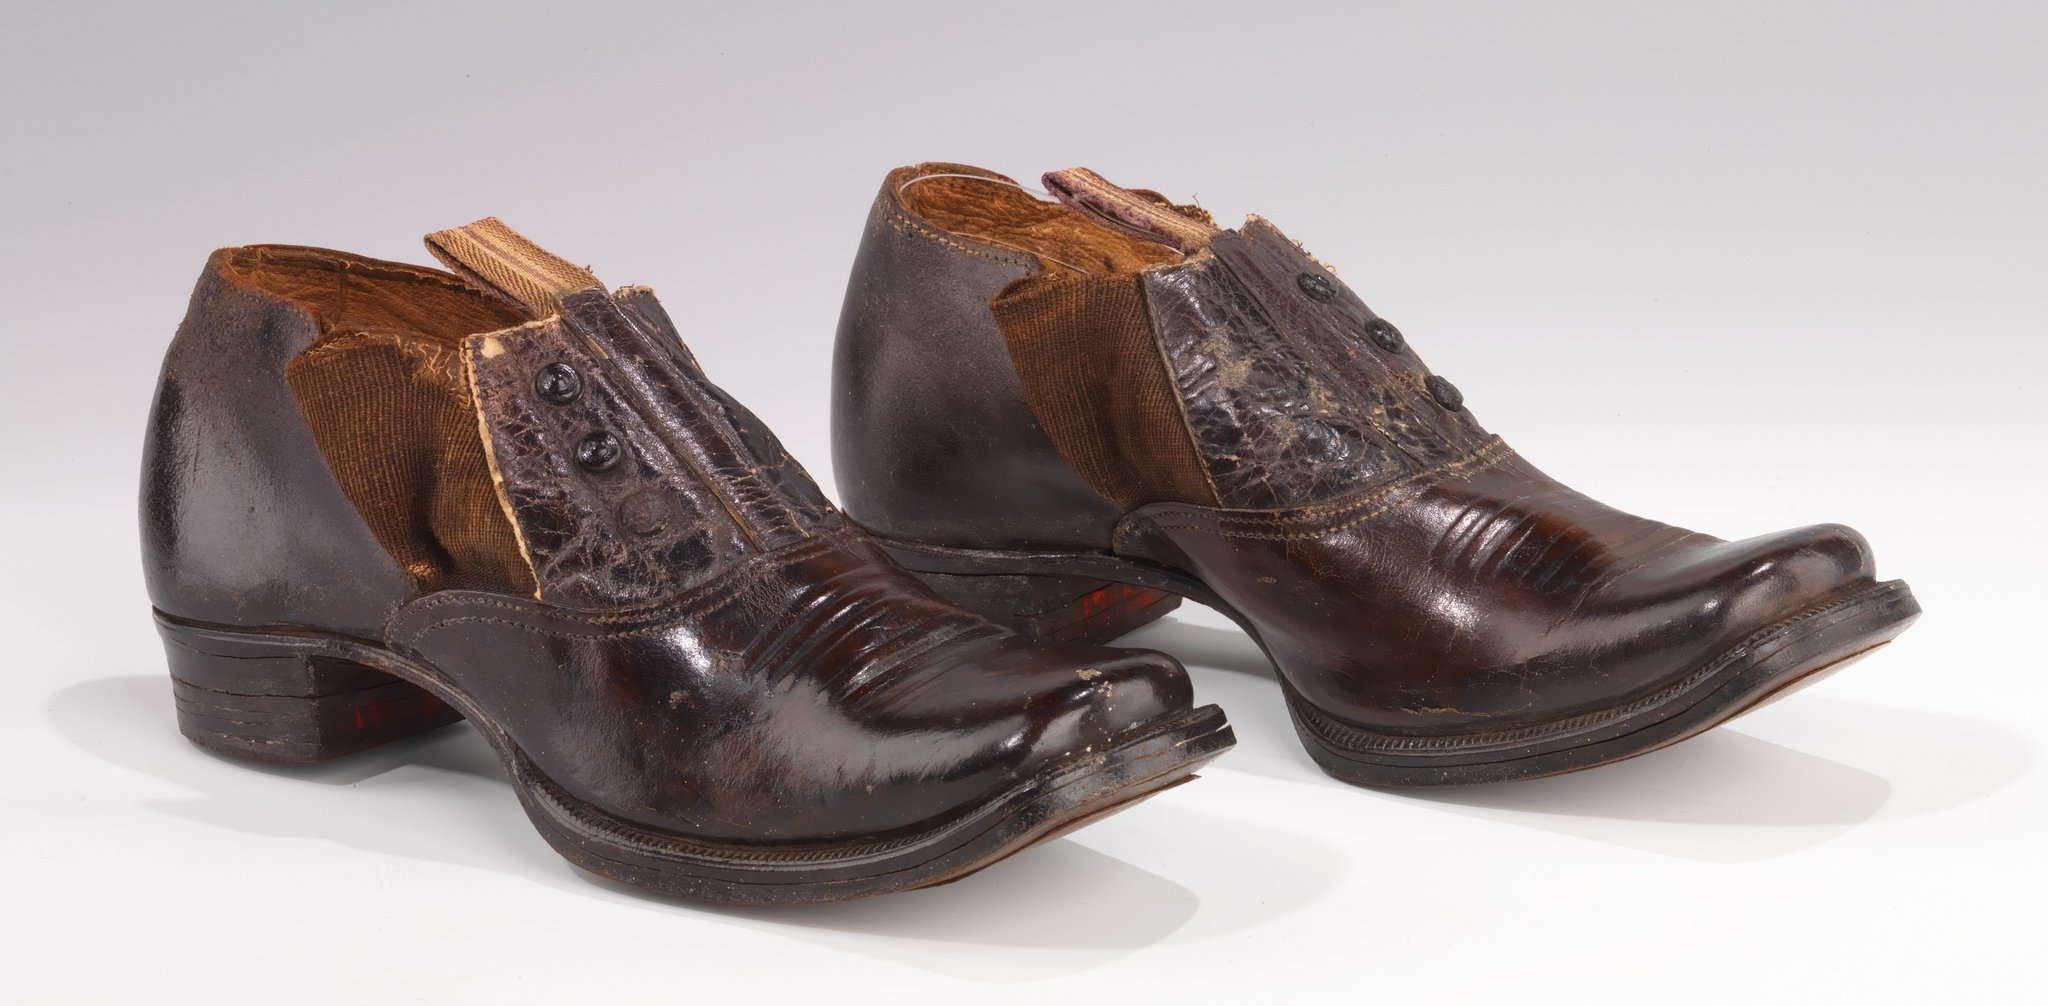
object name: shoe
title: Shoes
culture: american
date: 1890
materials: leather